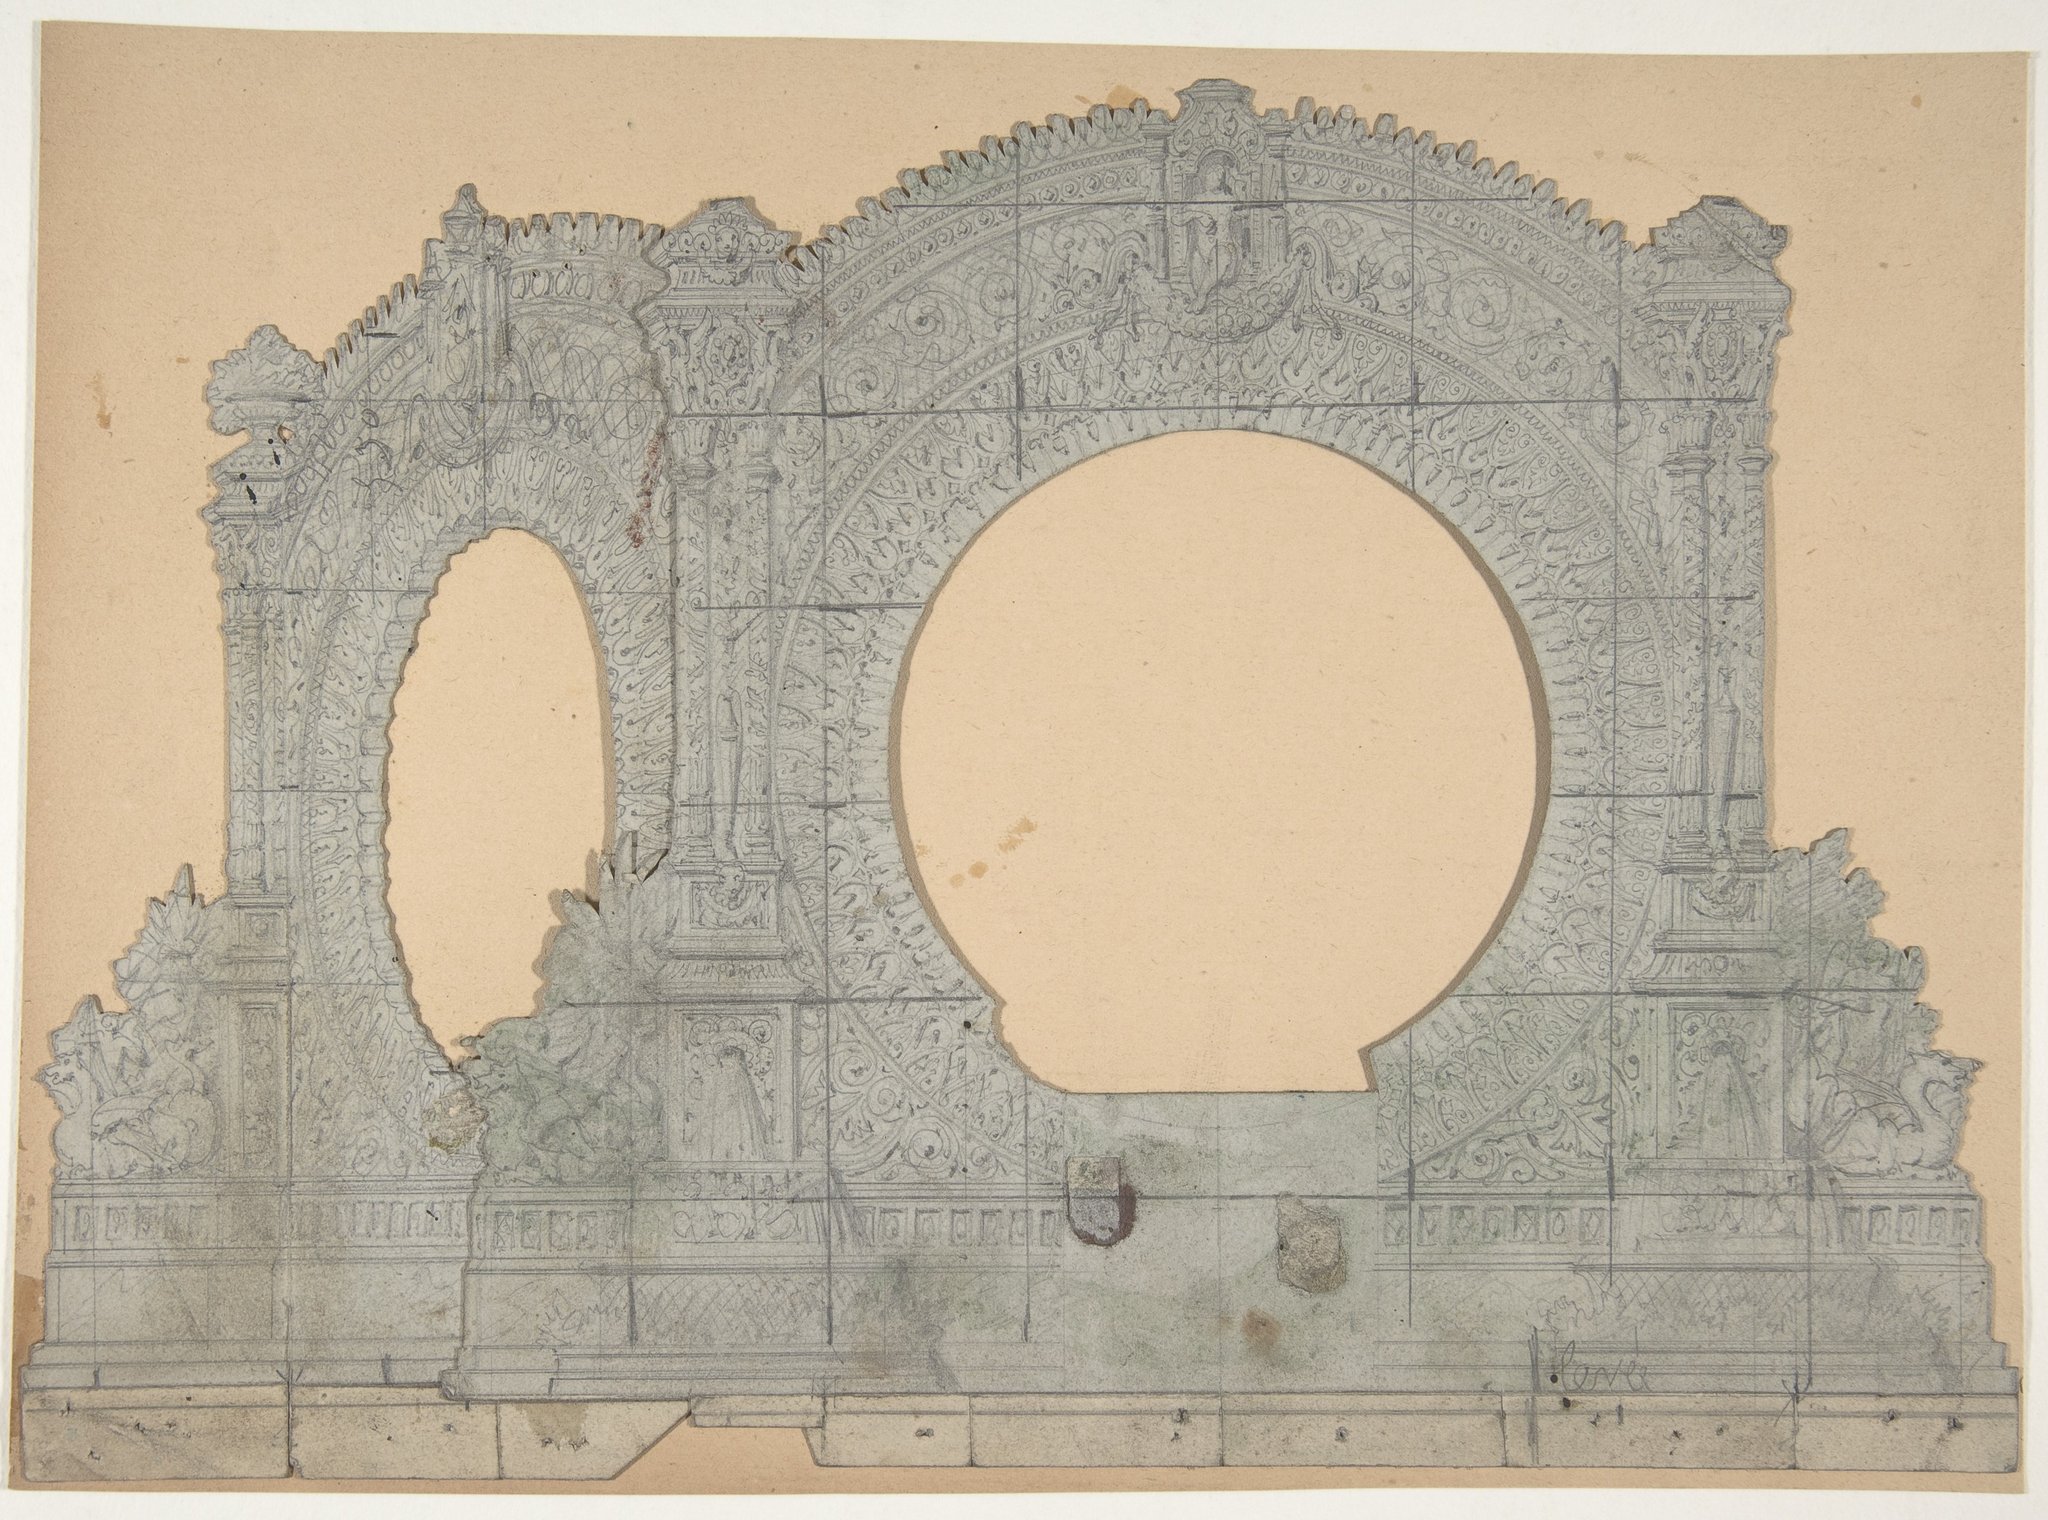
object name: drawing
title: Design for a Stage Set at the Opéra, Paris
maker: eugène cicéri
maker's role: artist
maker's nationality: french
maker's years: 1813-1890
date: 1830-1890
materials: graphite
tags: stage design